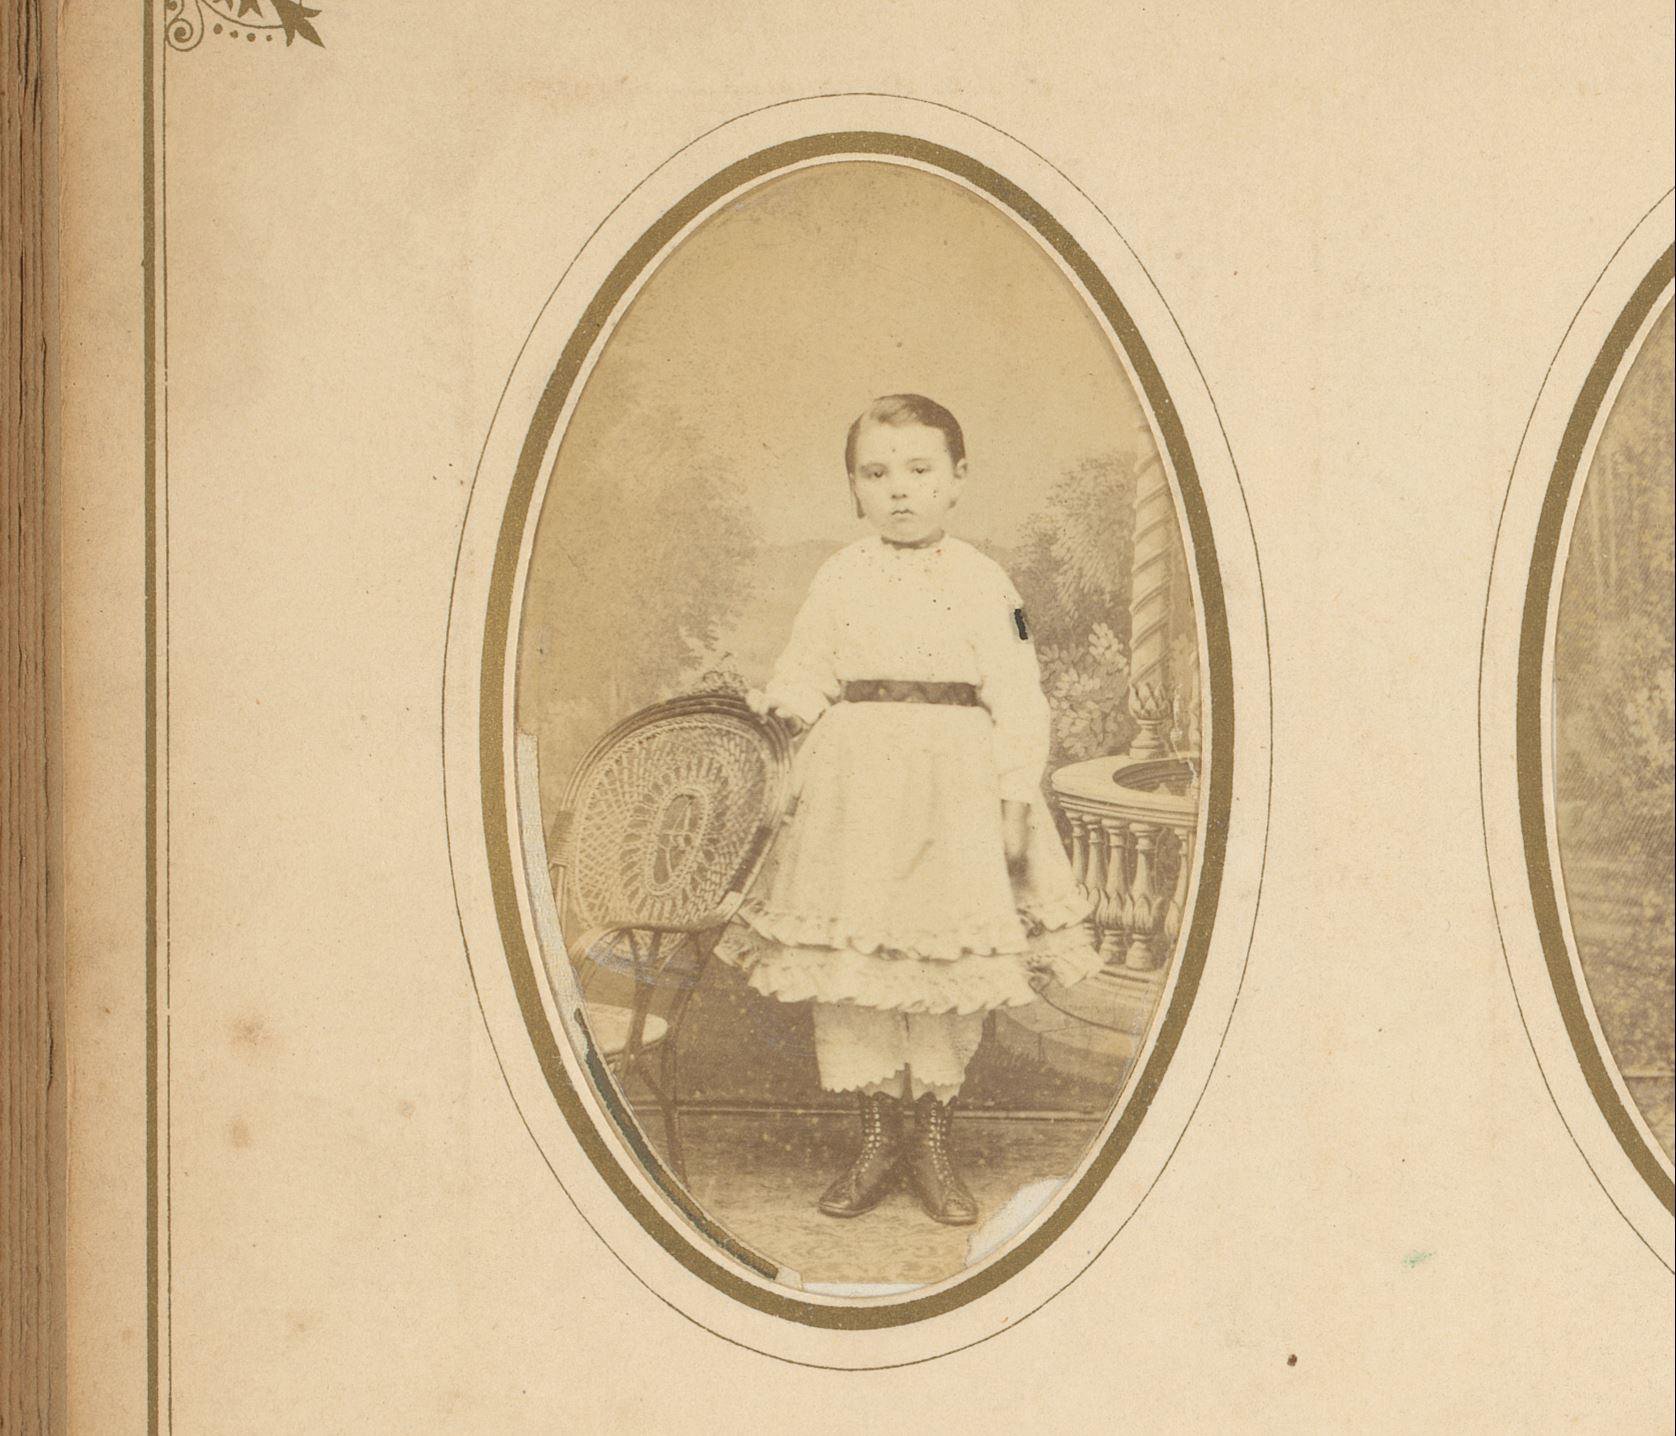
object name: album leaf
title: Portret van een meisje, staand bij een stoel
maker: benjamin van der heide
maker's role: fotograaf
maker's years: 1837-1928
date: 1866-1877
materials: cardboard, photographic support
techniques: albumen print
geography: harlingen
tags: historical persons - bb - woman, toddler (female), chair